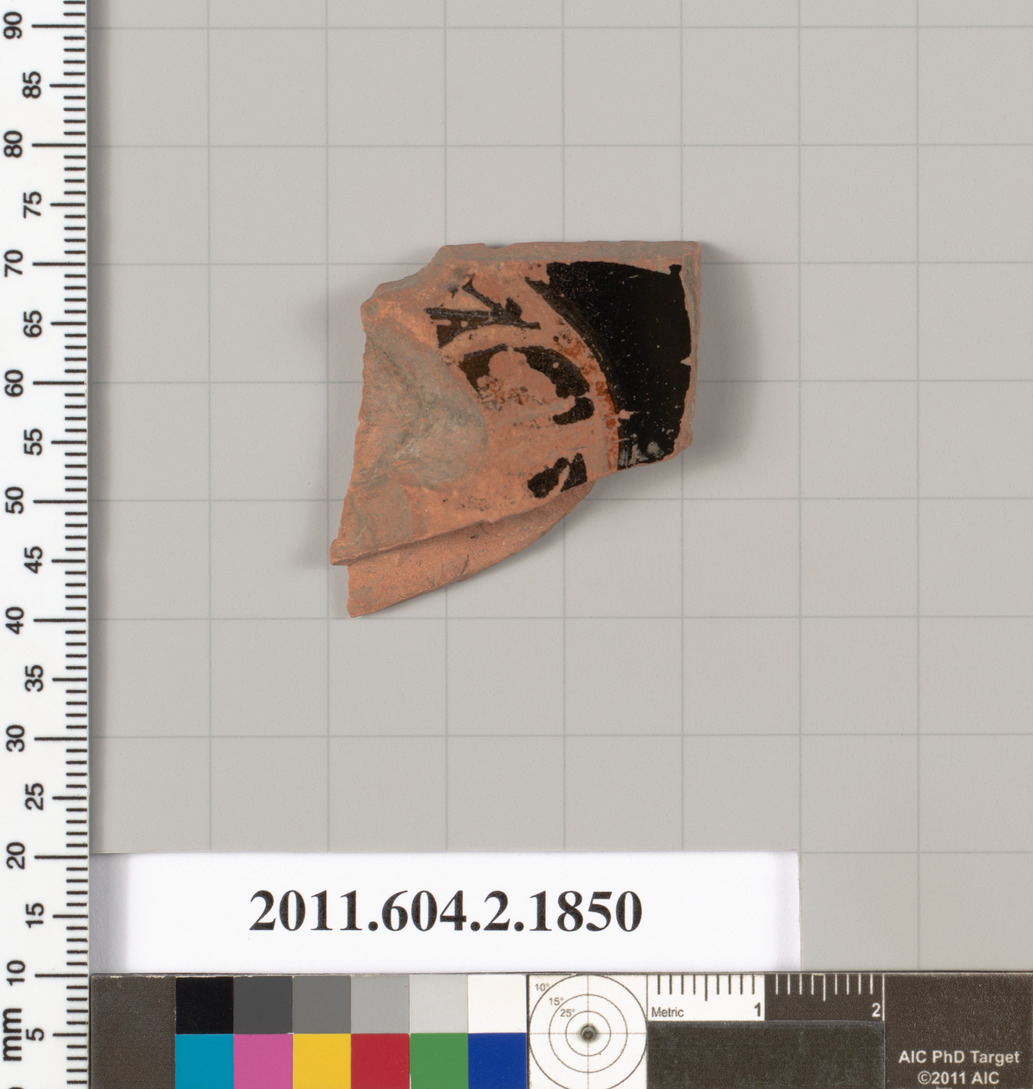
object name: skyphos fragment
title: Terracotta fragment of a skyphos (deep drinking cup)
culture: greek, attic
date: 450-426 BCE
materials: terracotta